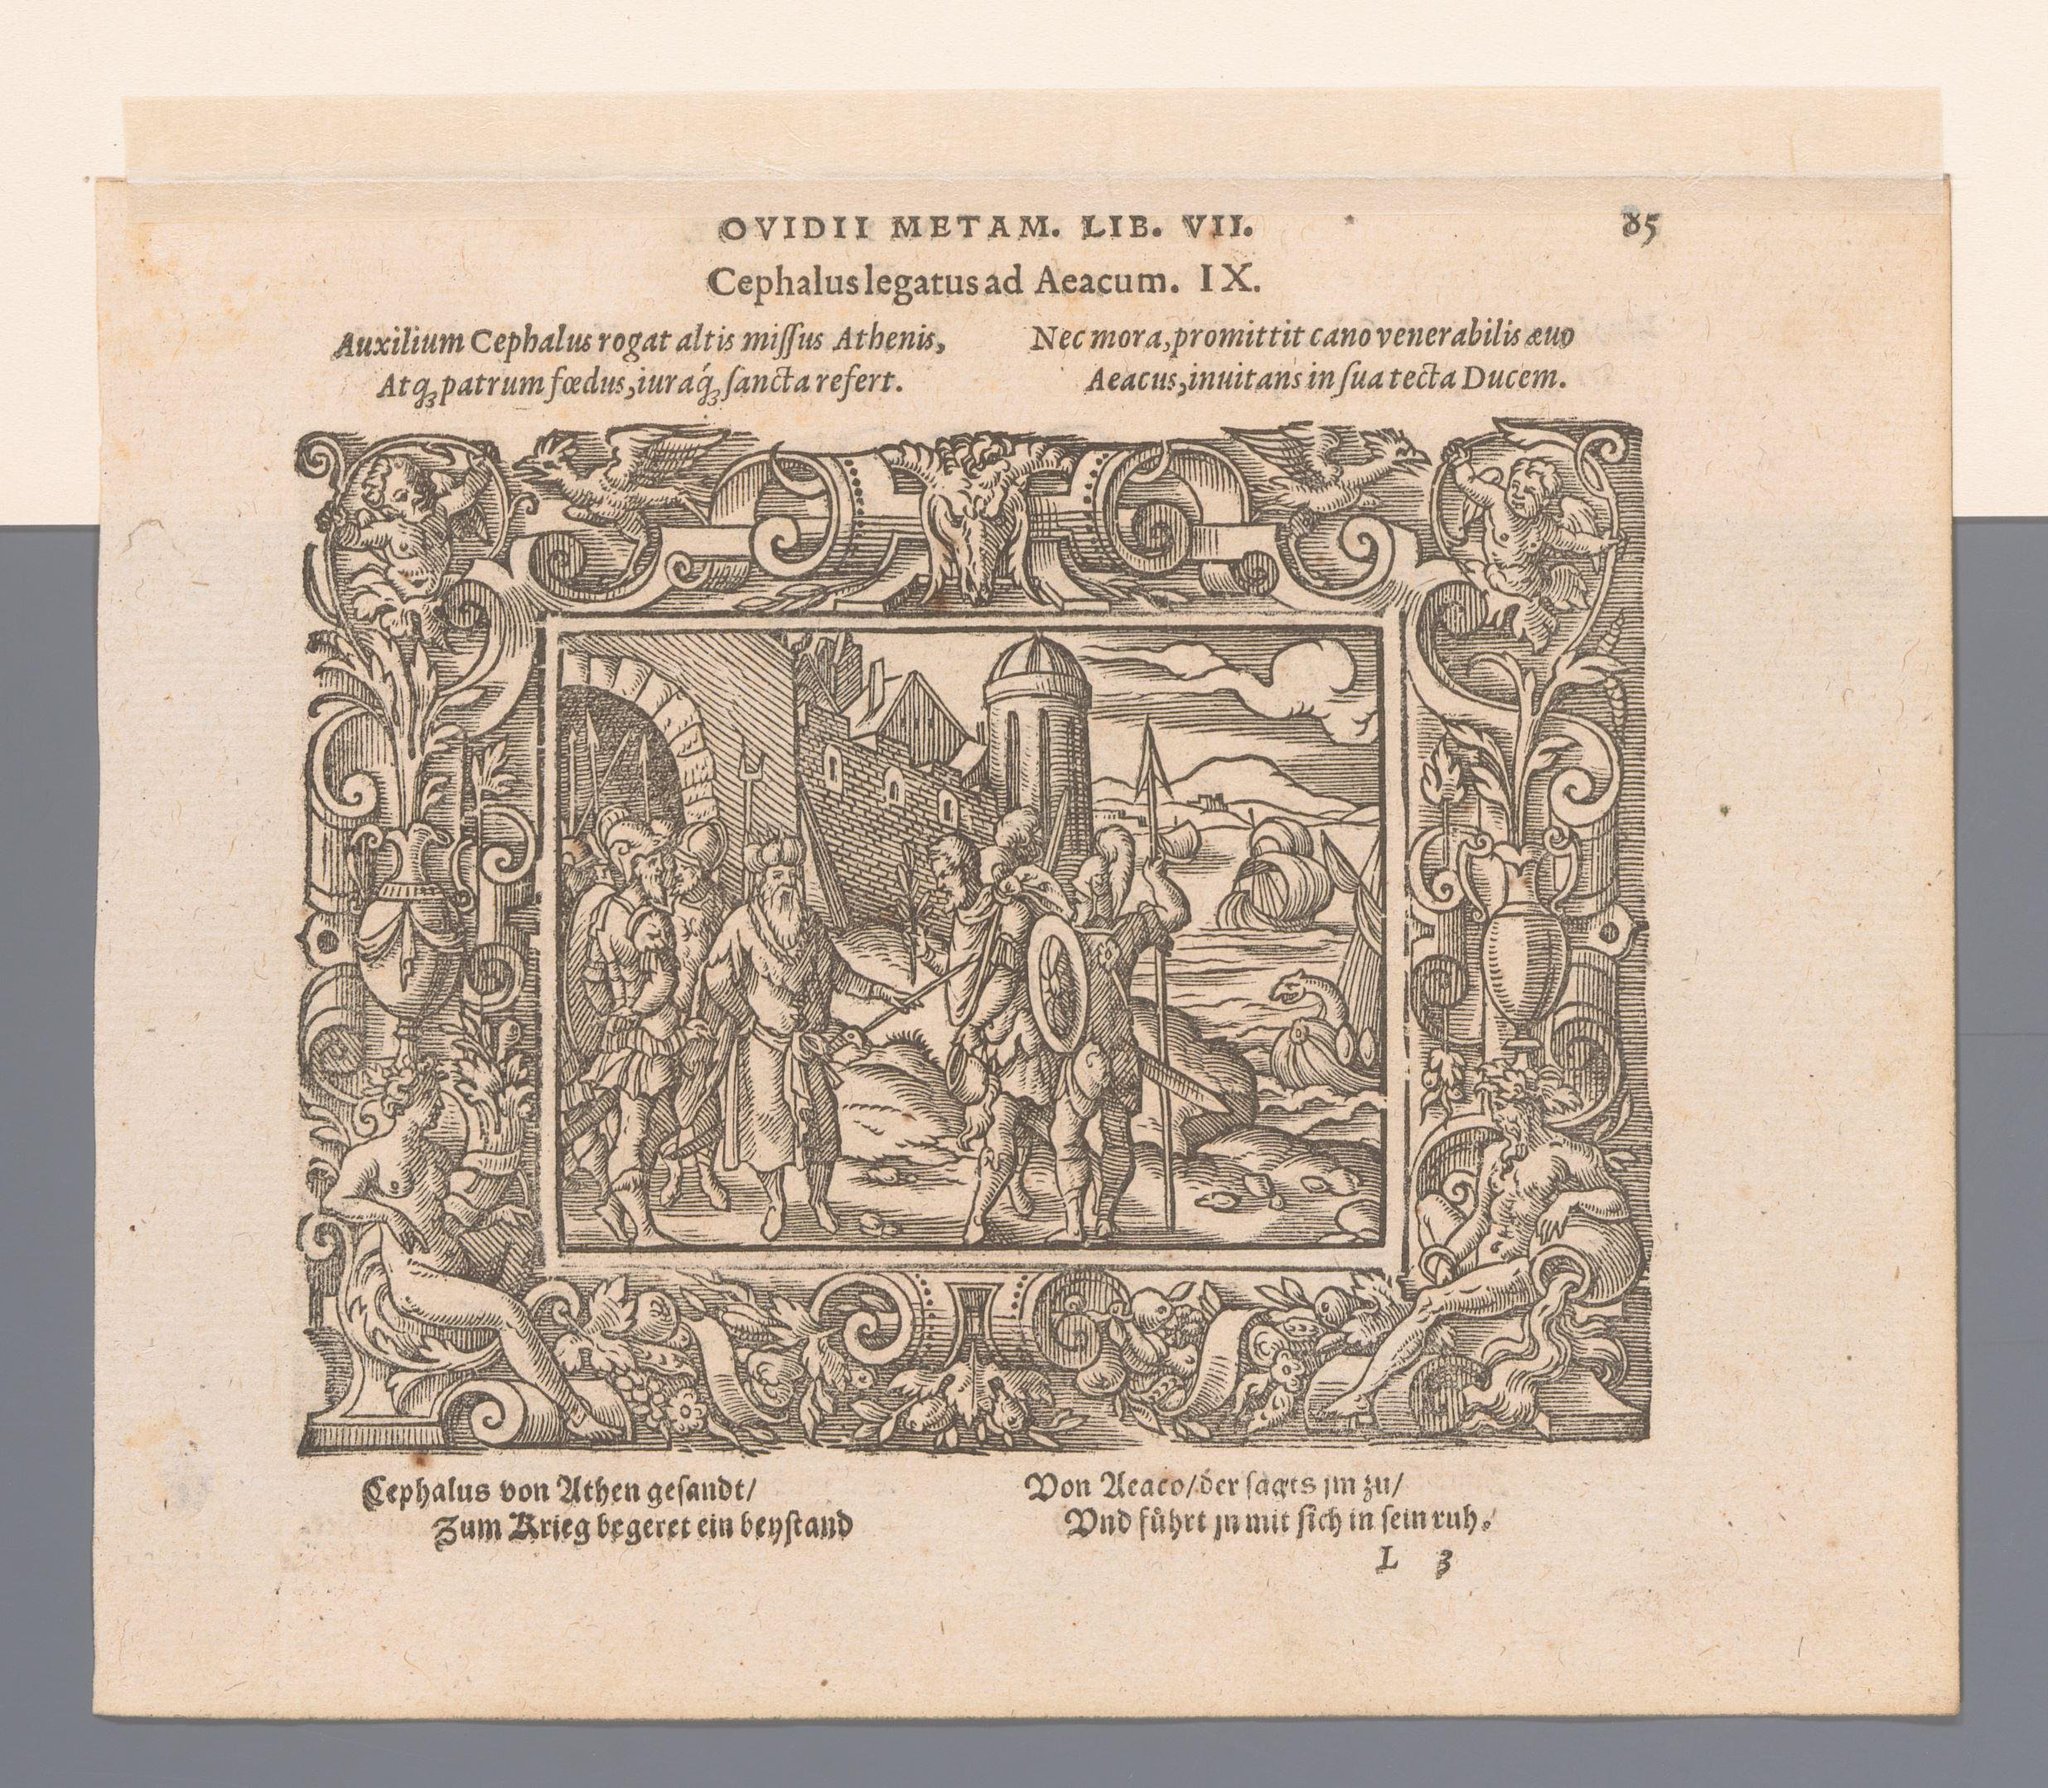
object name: book illustration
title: Cephalus legatus ad Aeacum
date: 1569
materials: paper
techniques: letterpress printing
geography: frankfurt am main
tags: scrollwork, strapwork ~ ornament, (story of) cephalus, (story of) aeacus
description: Illustratie bij de Metamorfosen van Ovidius, afkomstig uit de publicatie: Posthius, Johannes. Tetrasticha in Ovidii metam. Frankfurt am Main: Georg Rab en Sigmund Feyerabend en erven Weigand Han, 1569. De voorstellingen en ornamentranden van deze boekillustraties zijn van twee aparte blokken gedrukt. Beide werden afzonderlijk van elkaar ook gebruikt voor andere publicaties, en de ornamentranden werden eveneens binnen deze publicatie meerdere keren gebruikt.